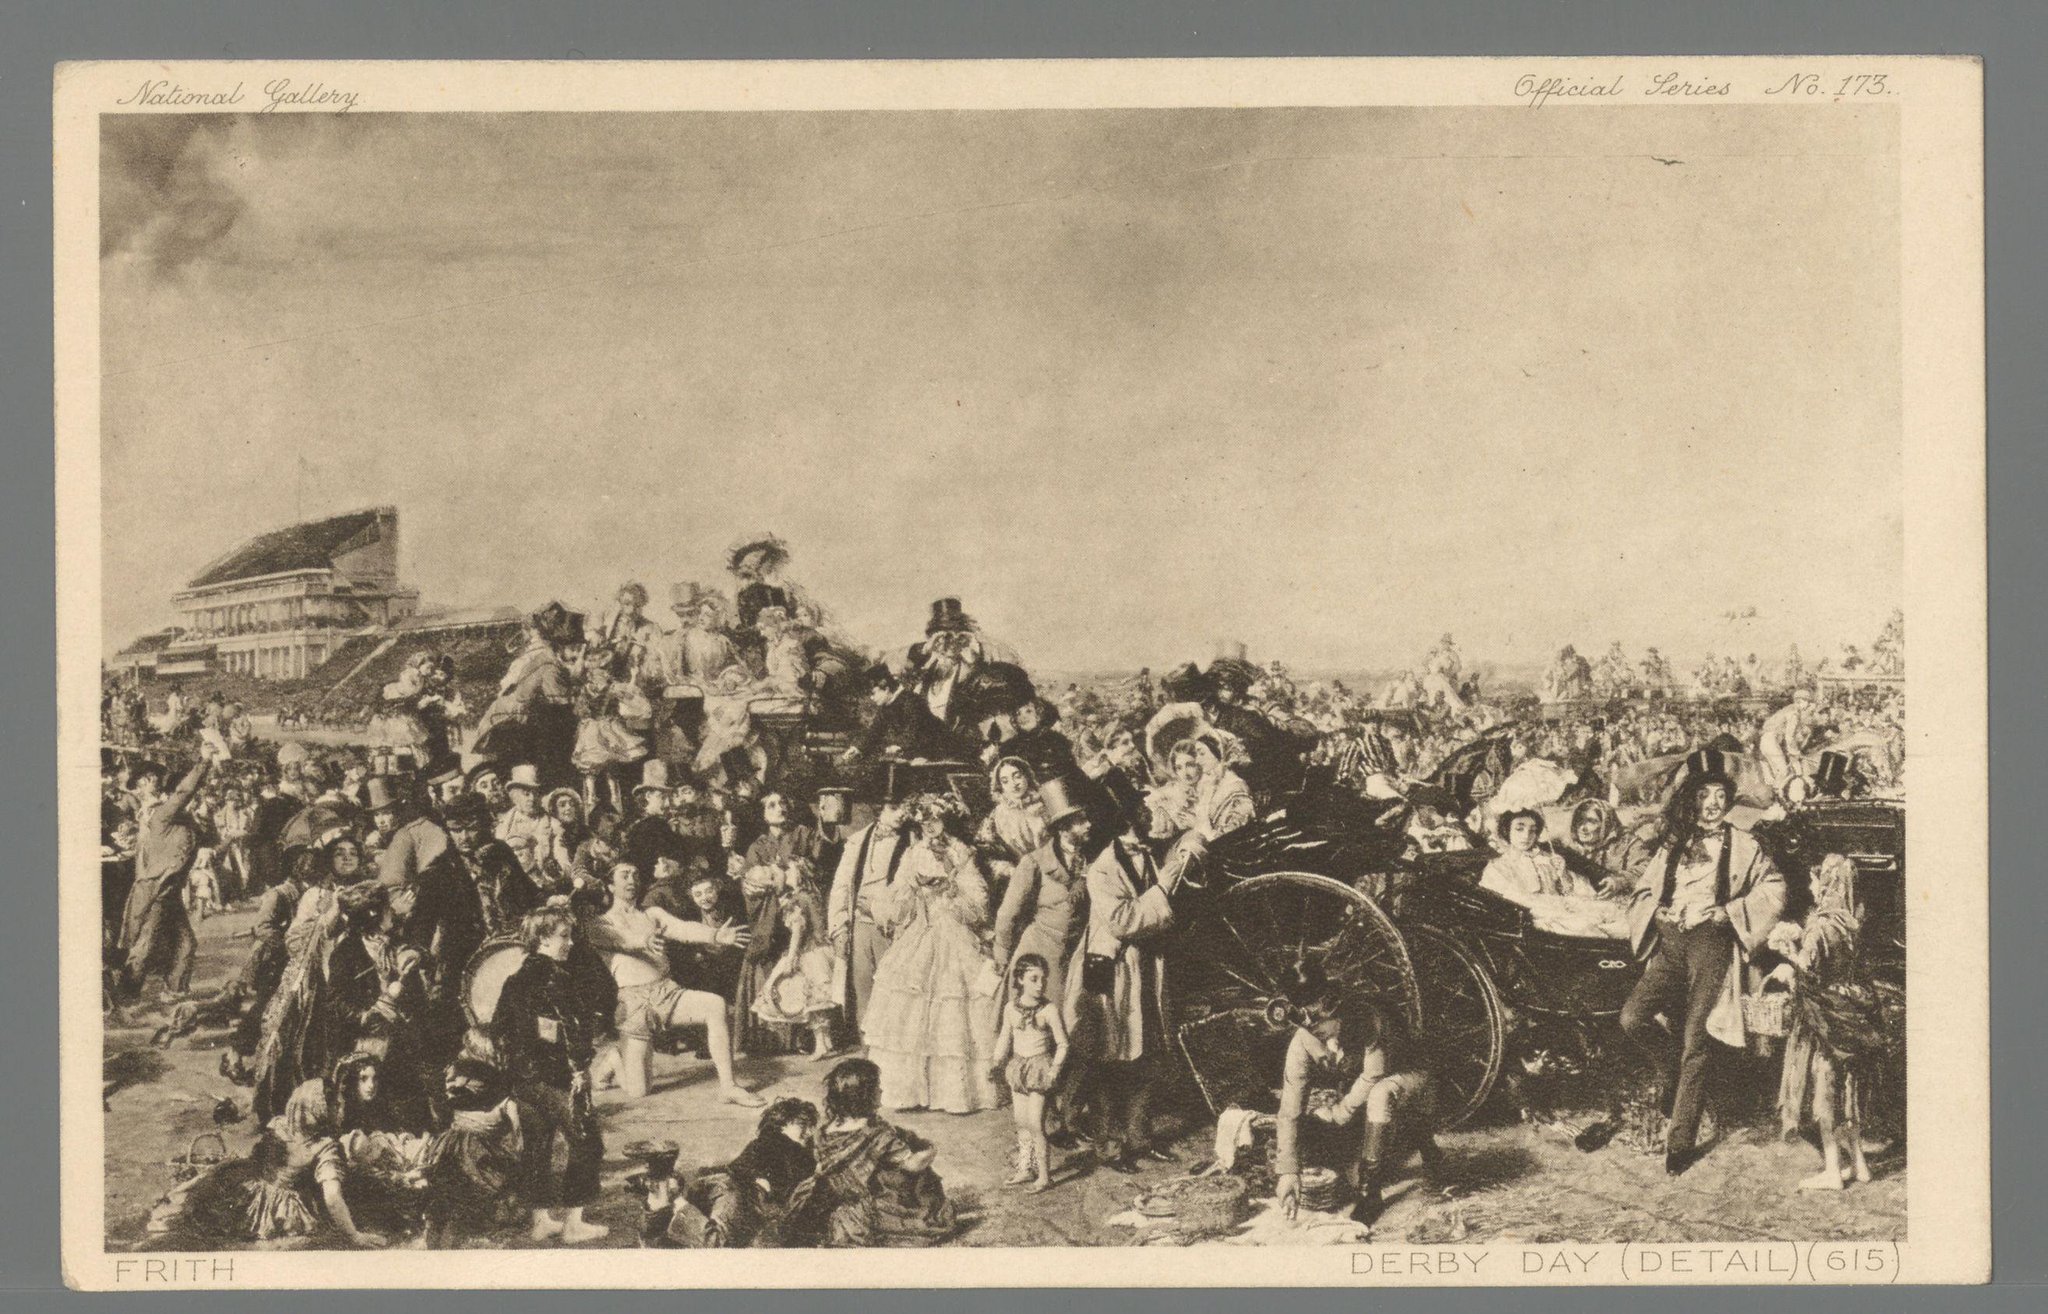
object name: photomechanical print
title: National Gallery. Official Series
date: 1915-1930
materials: cardboard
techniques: rotogravure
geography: watford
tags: picture, painting, london